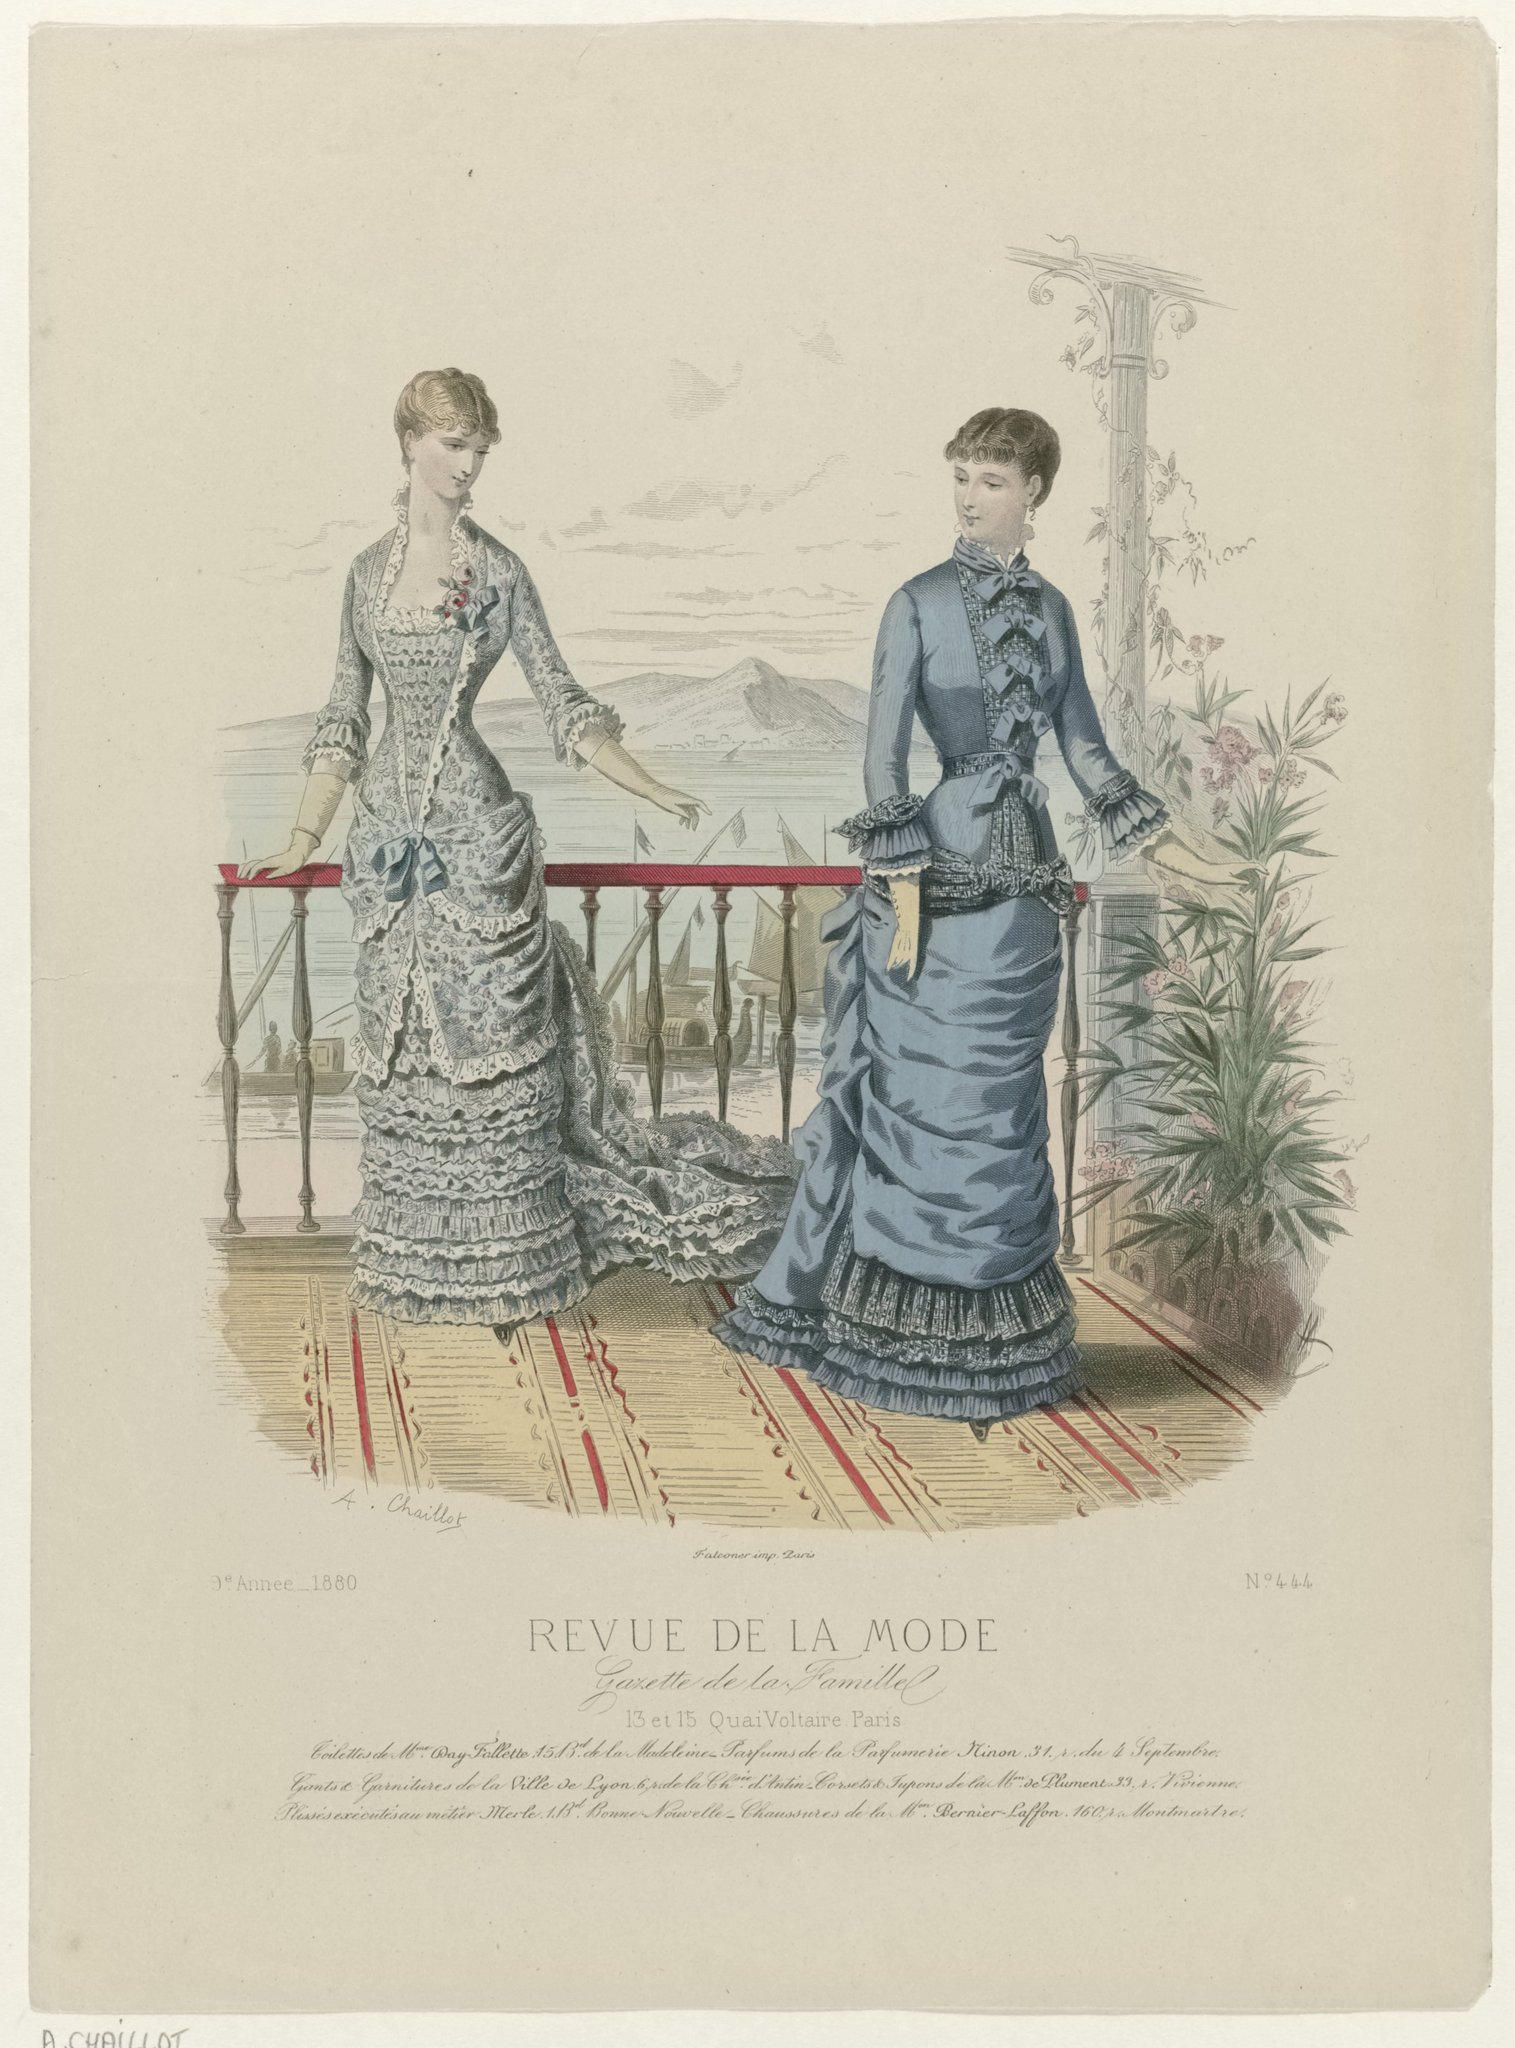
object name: fashion print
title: Revue de la Mode, Gazette de la Famille, dimanche 5 juillet 1880, 9e année, No. 444: Toilettes de Mme Day-Fallett (...)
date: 1880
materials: paper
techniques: engraving, hand coloring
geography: paris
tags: bow (ornamental part of clothing) (+ women's clothes), corsage (+ women's clothes), flowers, gloves, mittens (long gloves) (+ women's clothes), dress, gown: dinner dress (+ women's clothes), landscapes with waters, waterscapes, seascapes (in the temperate zone) (+ variant), fashion plates, balustrade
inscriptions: address: ‘13 et 15, Quai Voltaire, Paris’, caption: ‘Toilettes de M,me Day-Fallette, 15, Bd de la Madeleine_ Parfums de la parfumerie Ninon, 31 r. du 4 Septembre. Gants & Garnitures de la Ville de Lyon, 6, r. de la Ch.sée d'Antin _ Corsets & Jupons de la M.on de Plument, 33, r, Vivienne. Plissés exécutés au métier Merle, 1, B.d Bonne Nouvelle_ Chaussures de la M.on Bernier-Laffon. 160. r. Montmartre.’, title: ‘REVUE DE LA MODE / Gazette de la Famille’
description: Twee vrouwen bij een balustrade, gekleed in japonnen van Day-Fallette. Links: dinerjapon van 'surah' bedrukt met 'fleurs pompadour' met een lijfje "Louis XV. . Rechts: meisjesjapon van blauwe voile. Onder de afbeelding enkele regels reclametekst voor verschillende producten. Prent uit het modetijdschrift Revue de la Mode (1872-1913). Uitgebreide beschrijving van de kleding op pagina 221 "PLANCHE COLORIÉE"